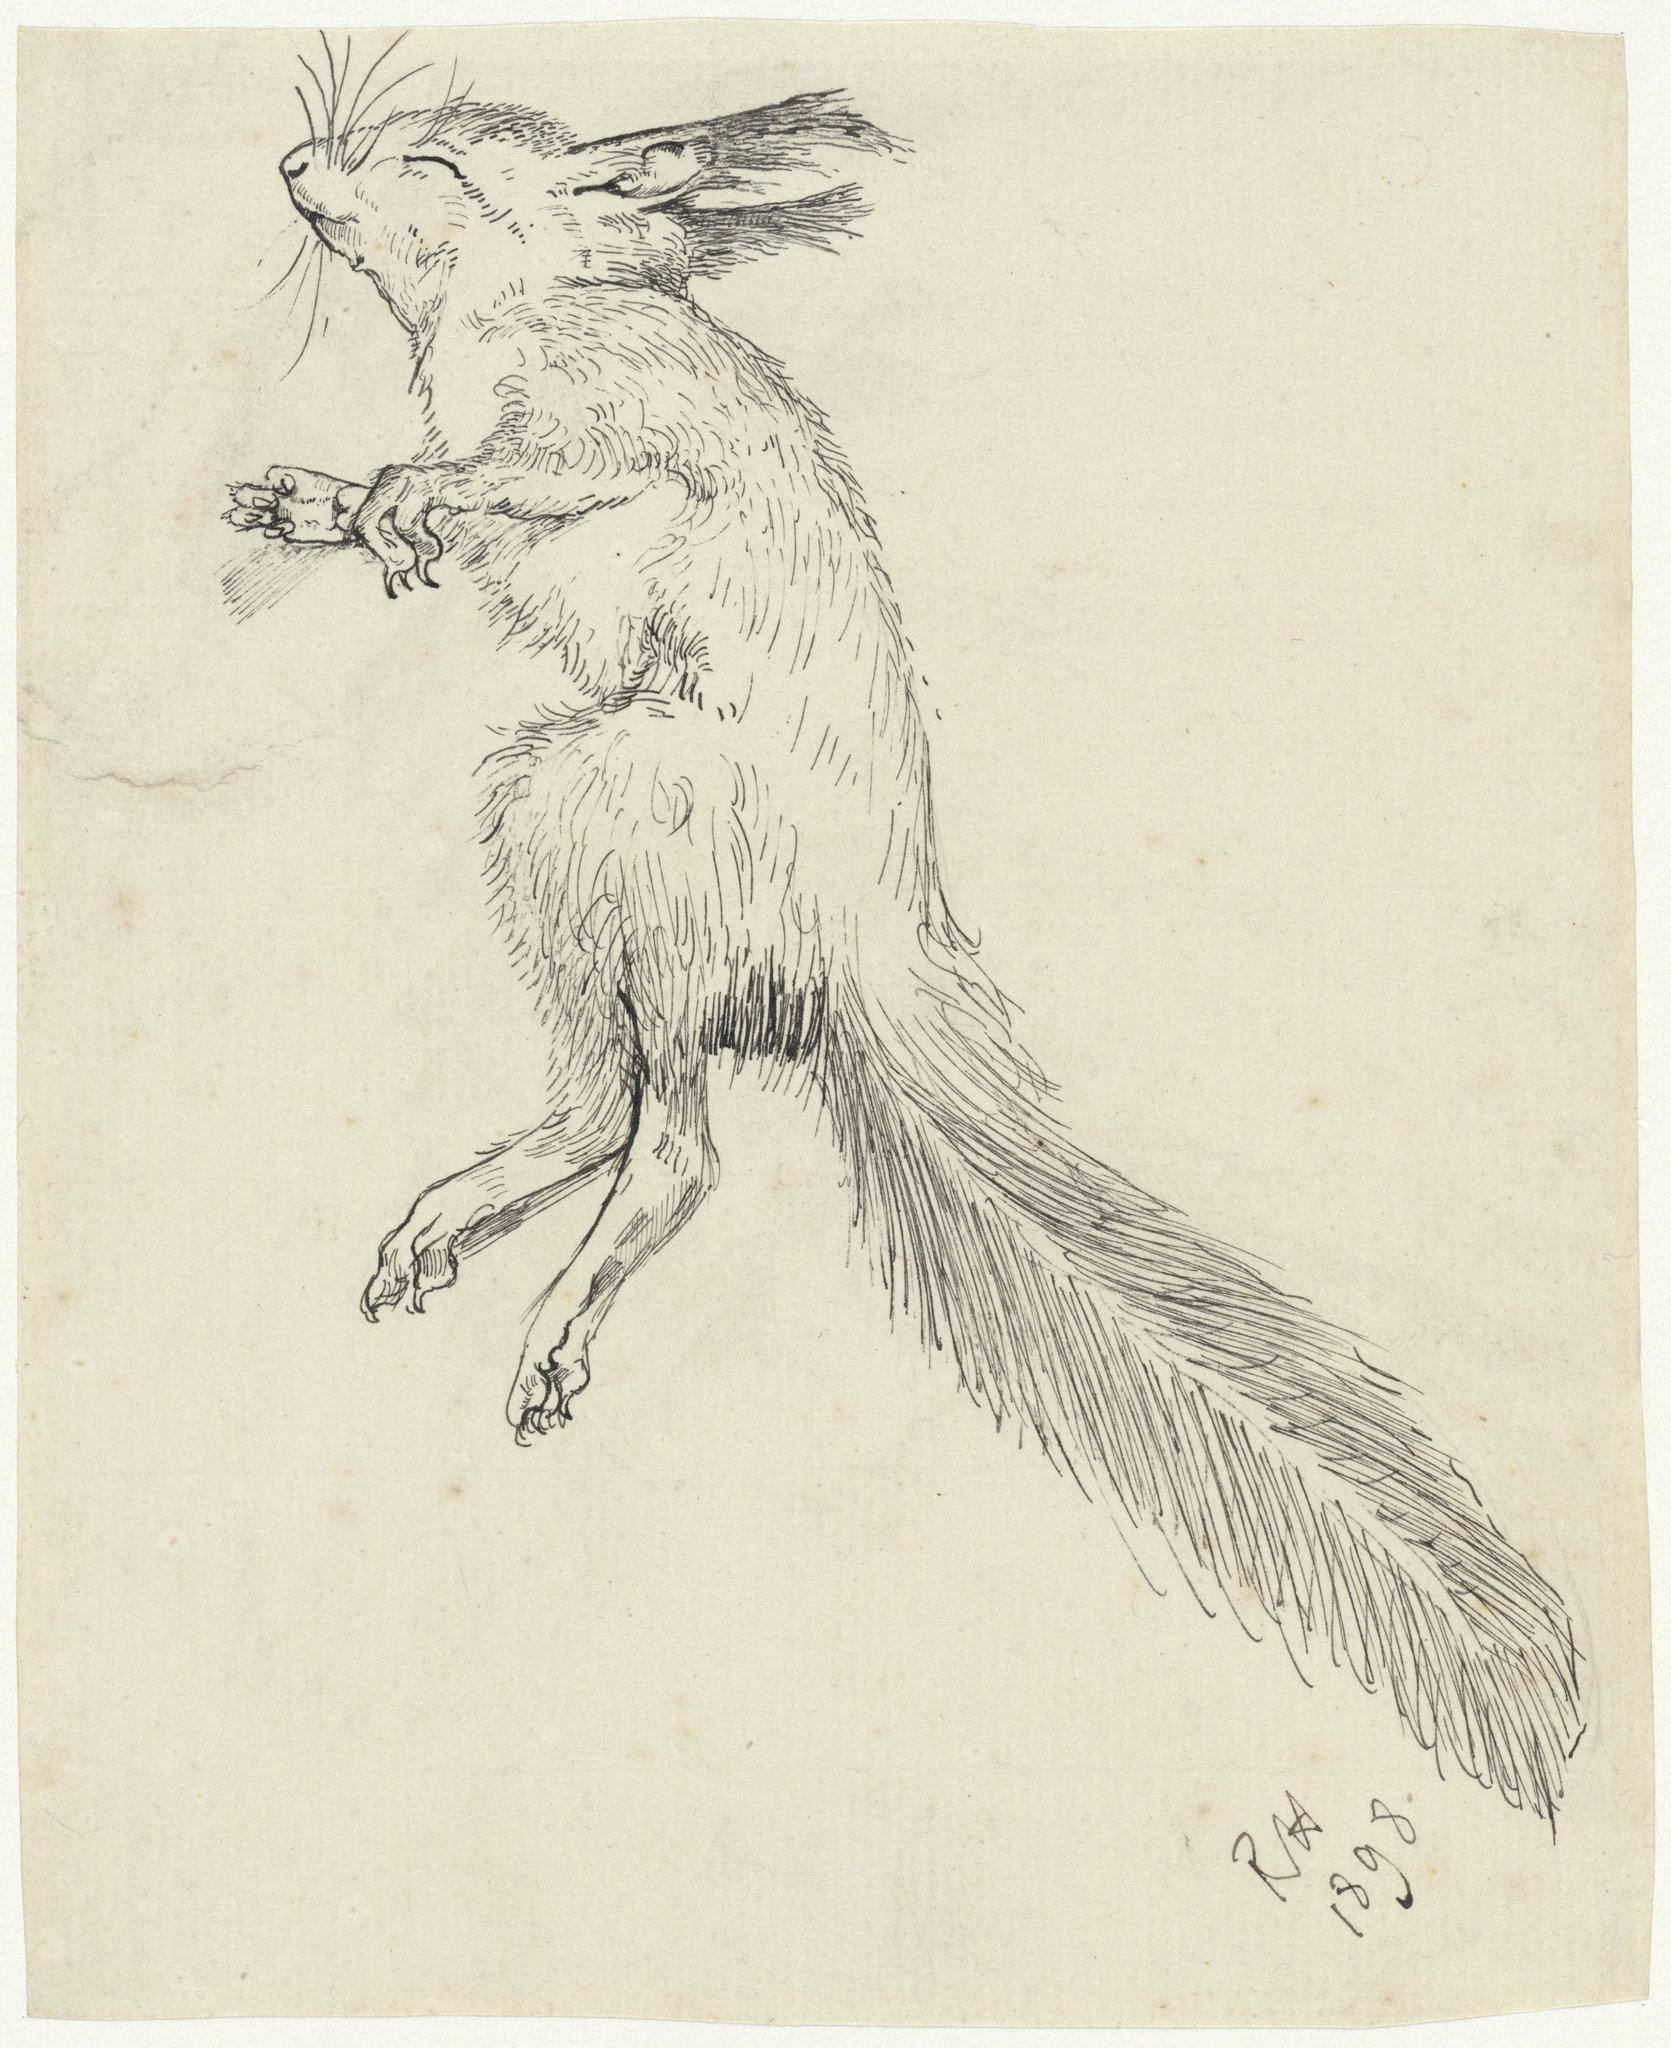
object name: drawing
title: Dode eekhoorn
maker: richard nicolaüs roland holst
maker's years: 1868-1938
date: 1898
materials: ink, paper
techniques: pen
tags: rodents: squirrel